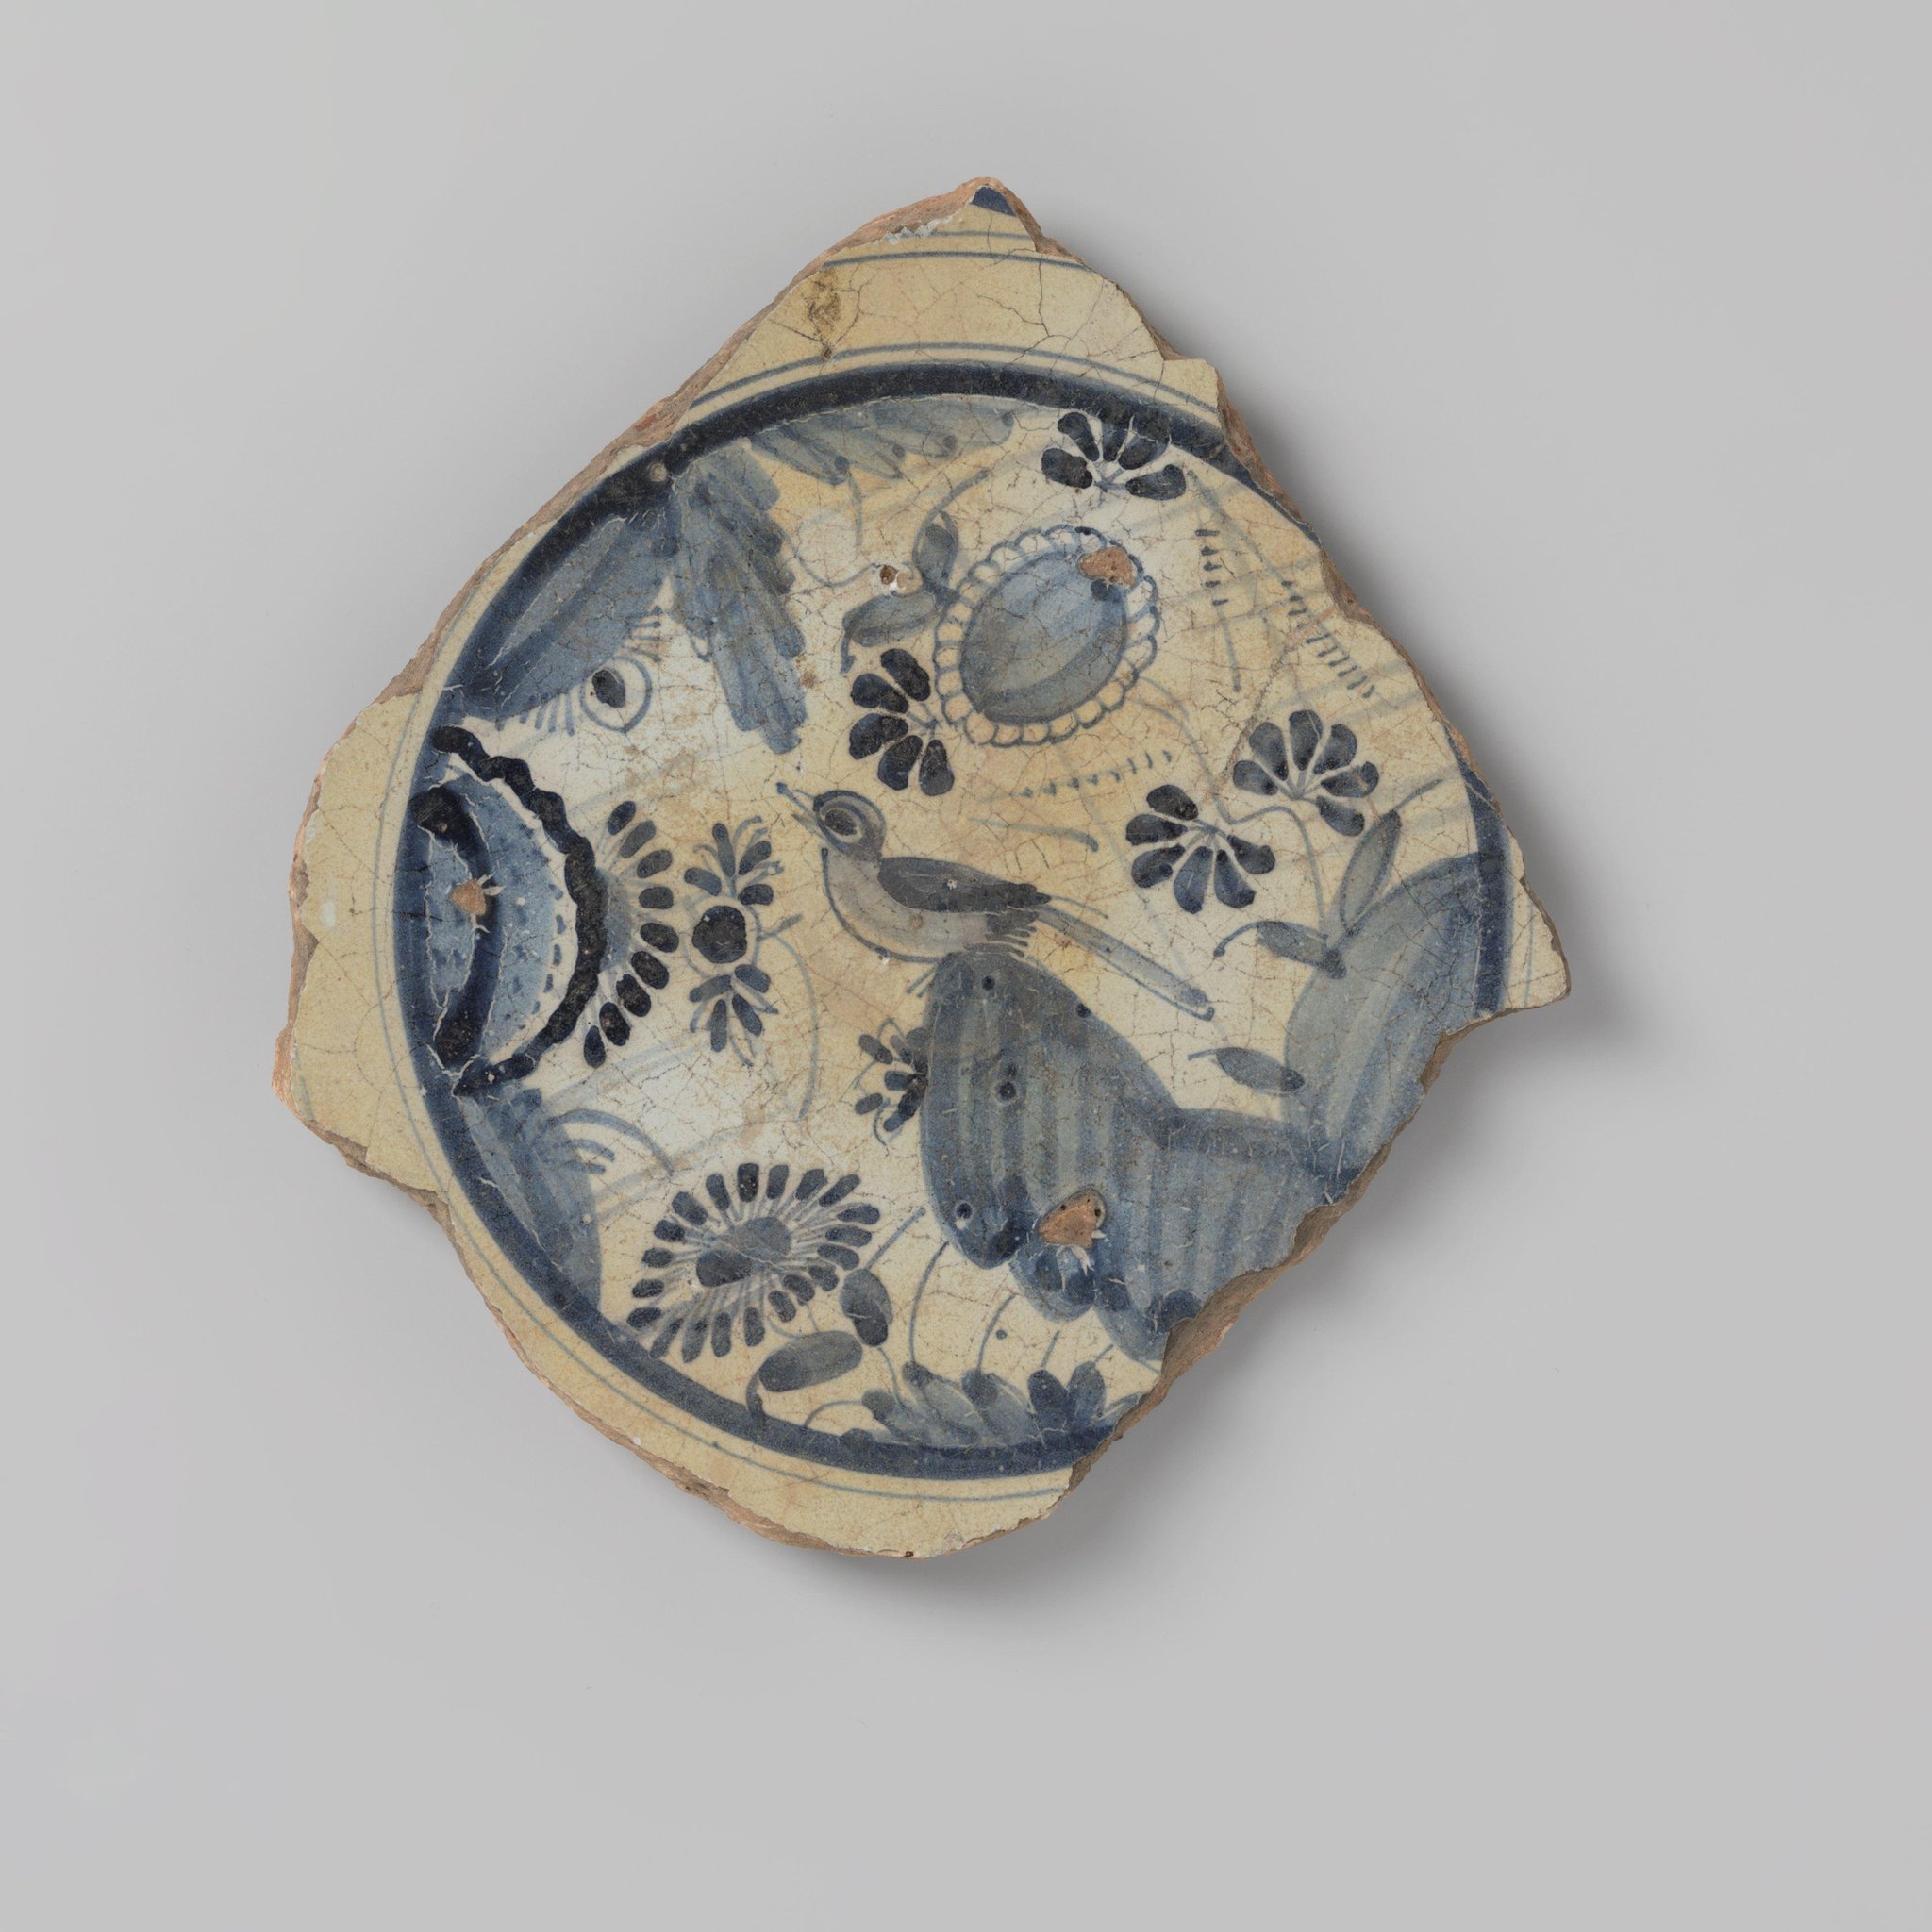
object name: sherd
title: Schotelscherf van aardewerk met tekening een cirkel, gevuld met bloemen en een vogel, in onderglazuur blauw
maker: Anonymous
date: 1500-1799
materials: earthenware, glaze